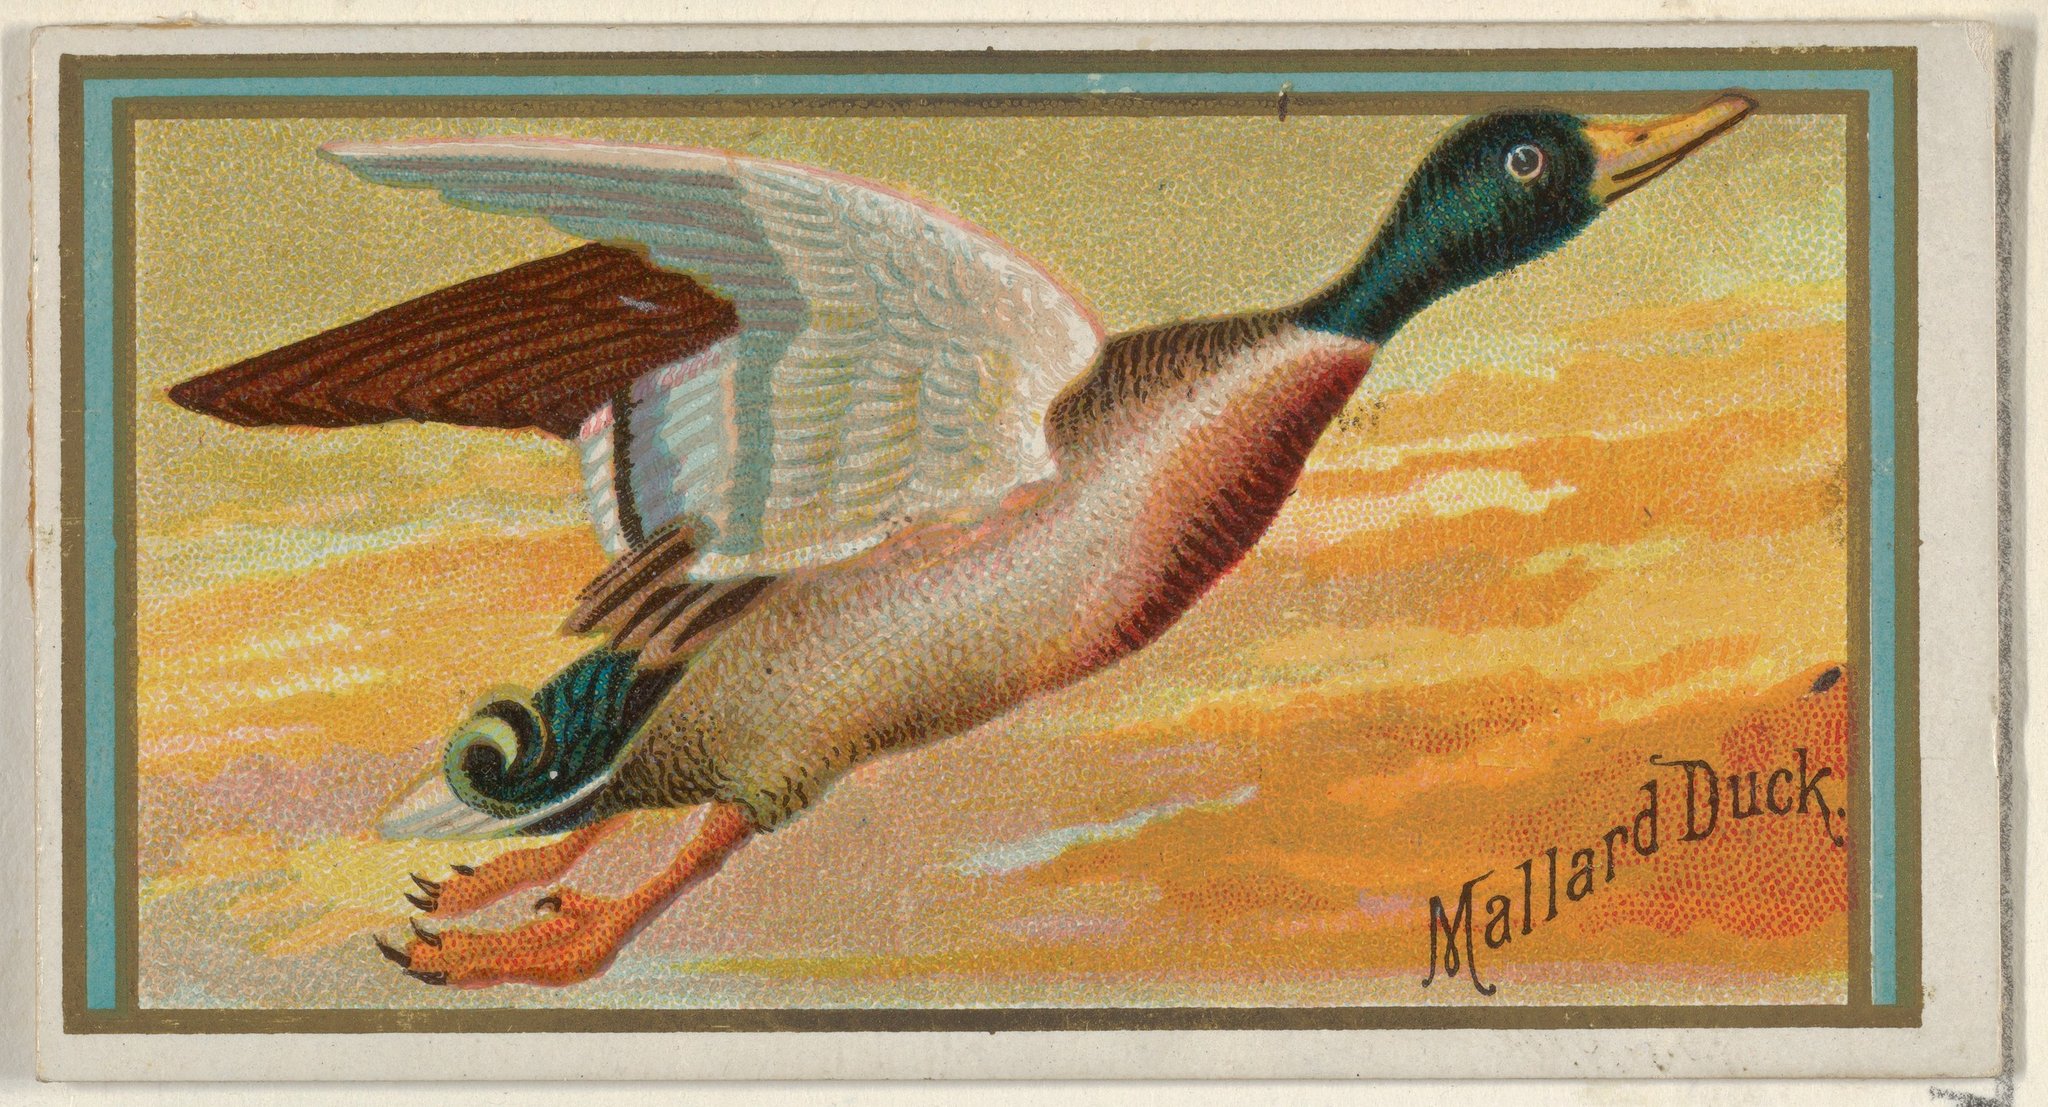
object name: print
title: Mallard Duck, from the Game Birds series (N13) for Allen & Ginter Cigarettes Brands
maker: allen & ginter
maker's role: publisher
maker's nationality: american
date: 1889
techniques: color lithograph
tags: ducks